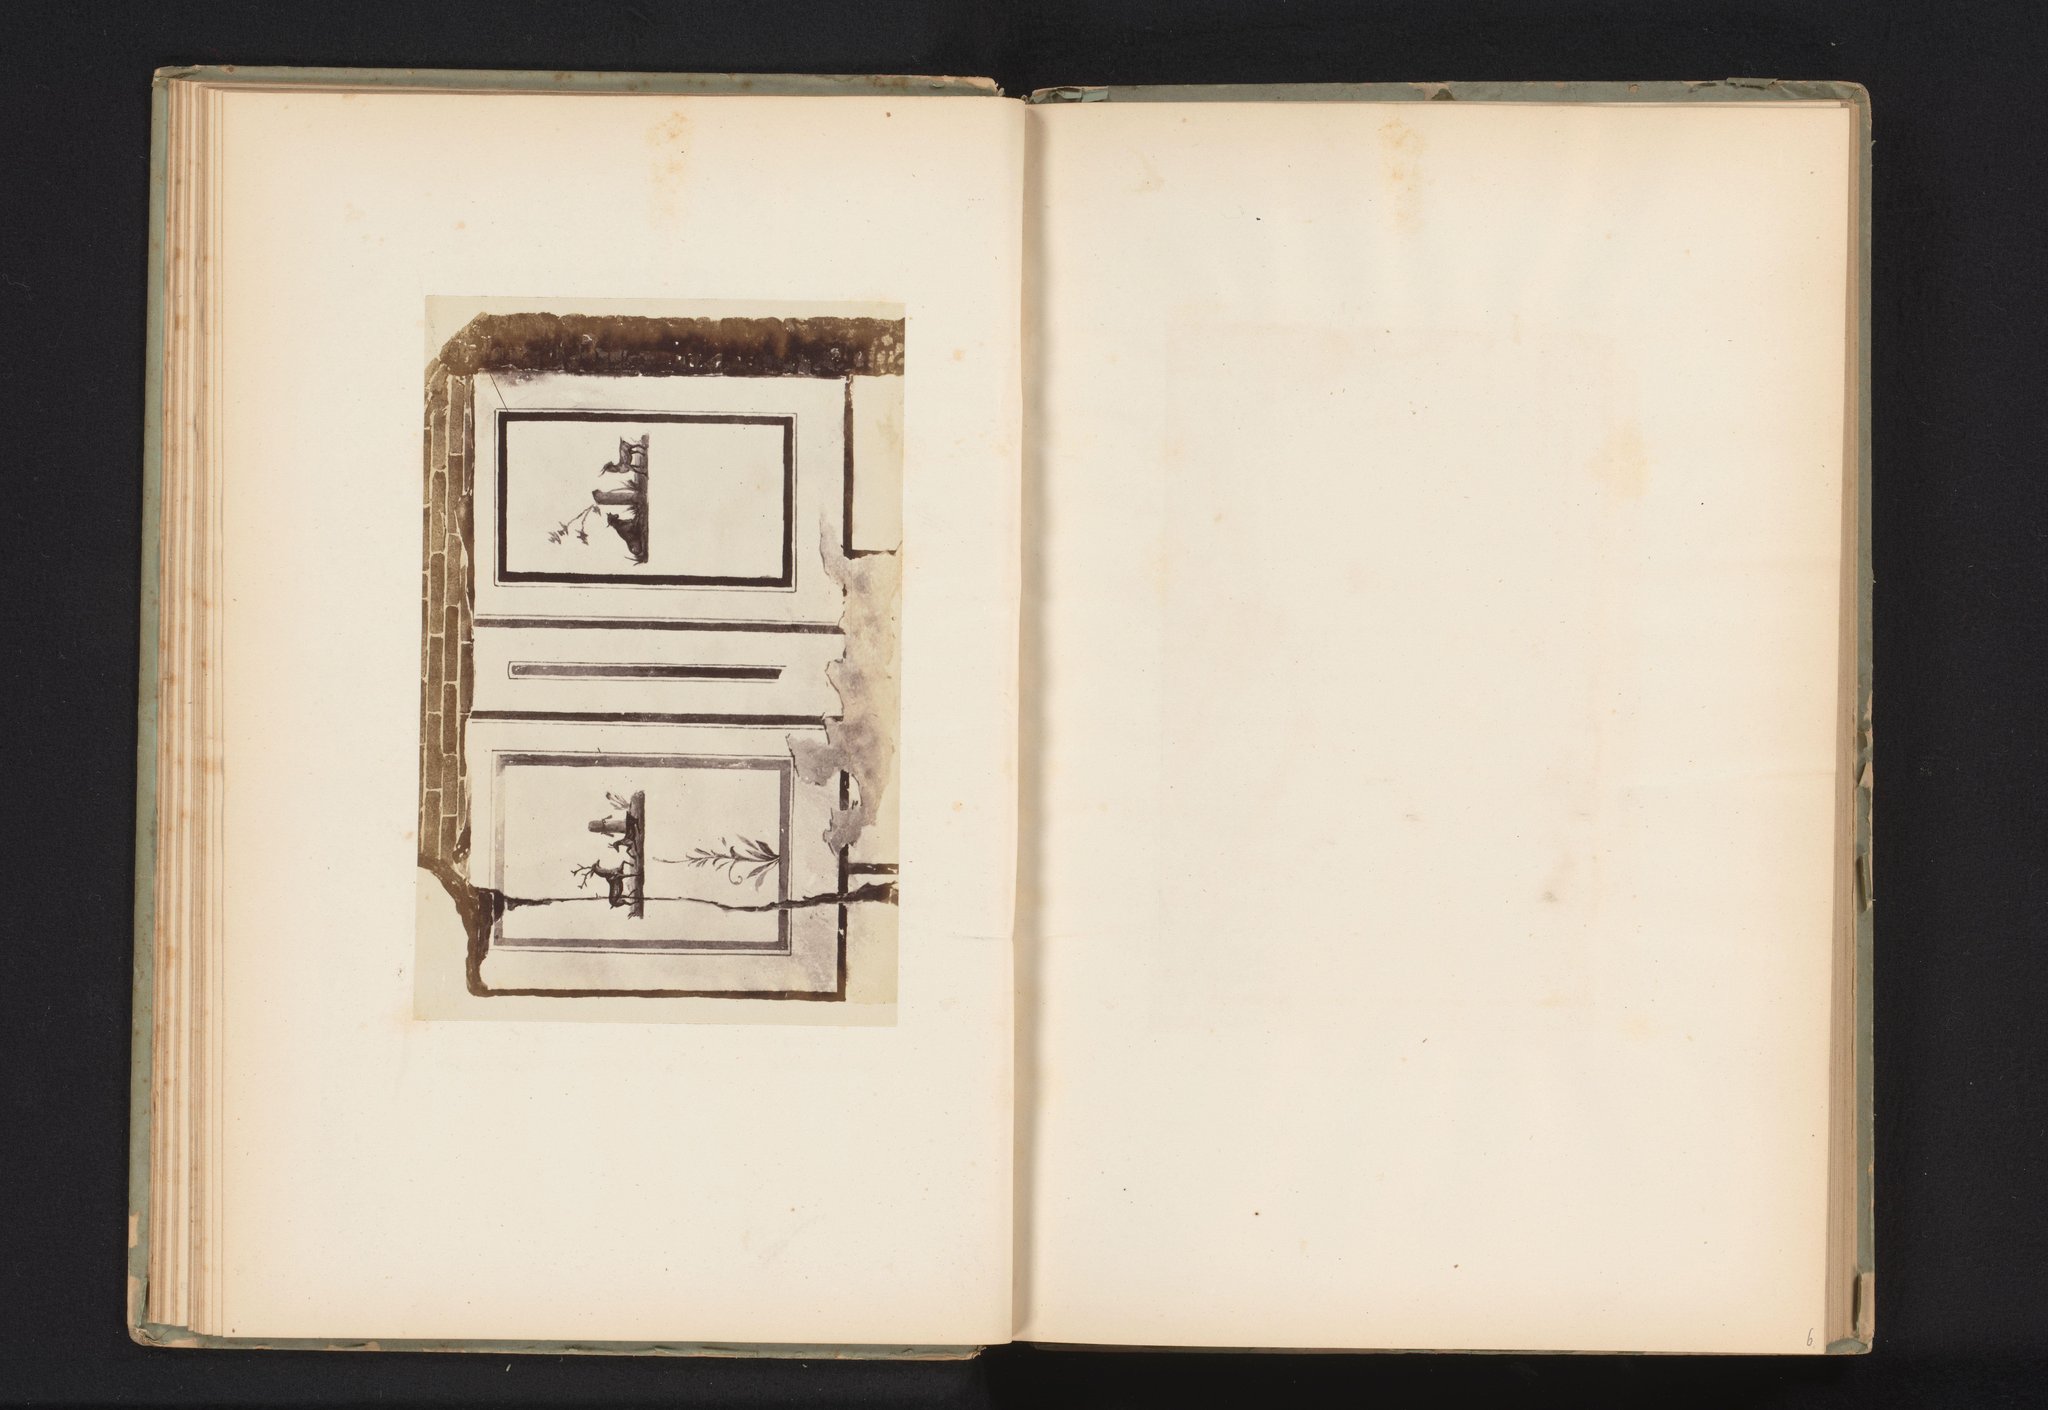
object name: page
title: Fotoreproductie van een schilderij, voorstellende een muurschildering in een opgegraven ruïne te Rome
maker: Anonymous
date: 1863-1873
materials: photographic support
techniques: albumen print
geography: rome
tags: hoofed animals: deer, picture, painting